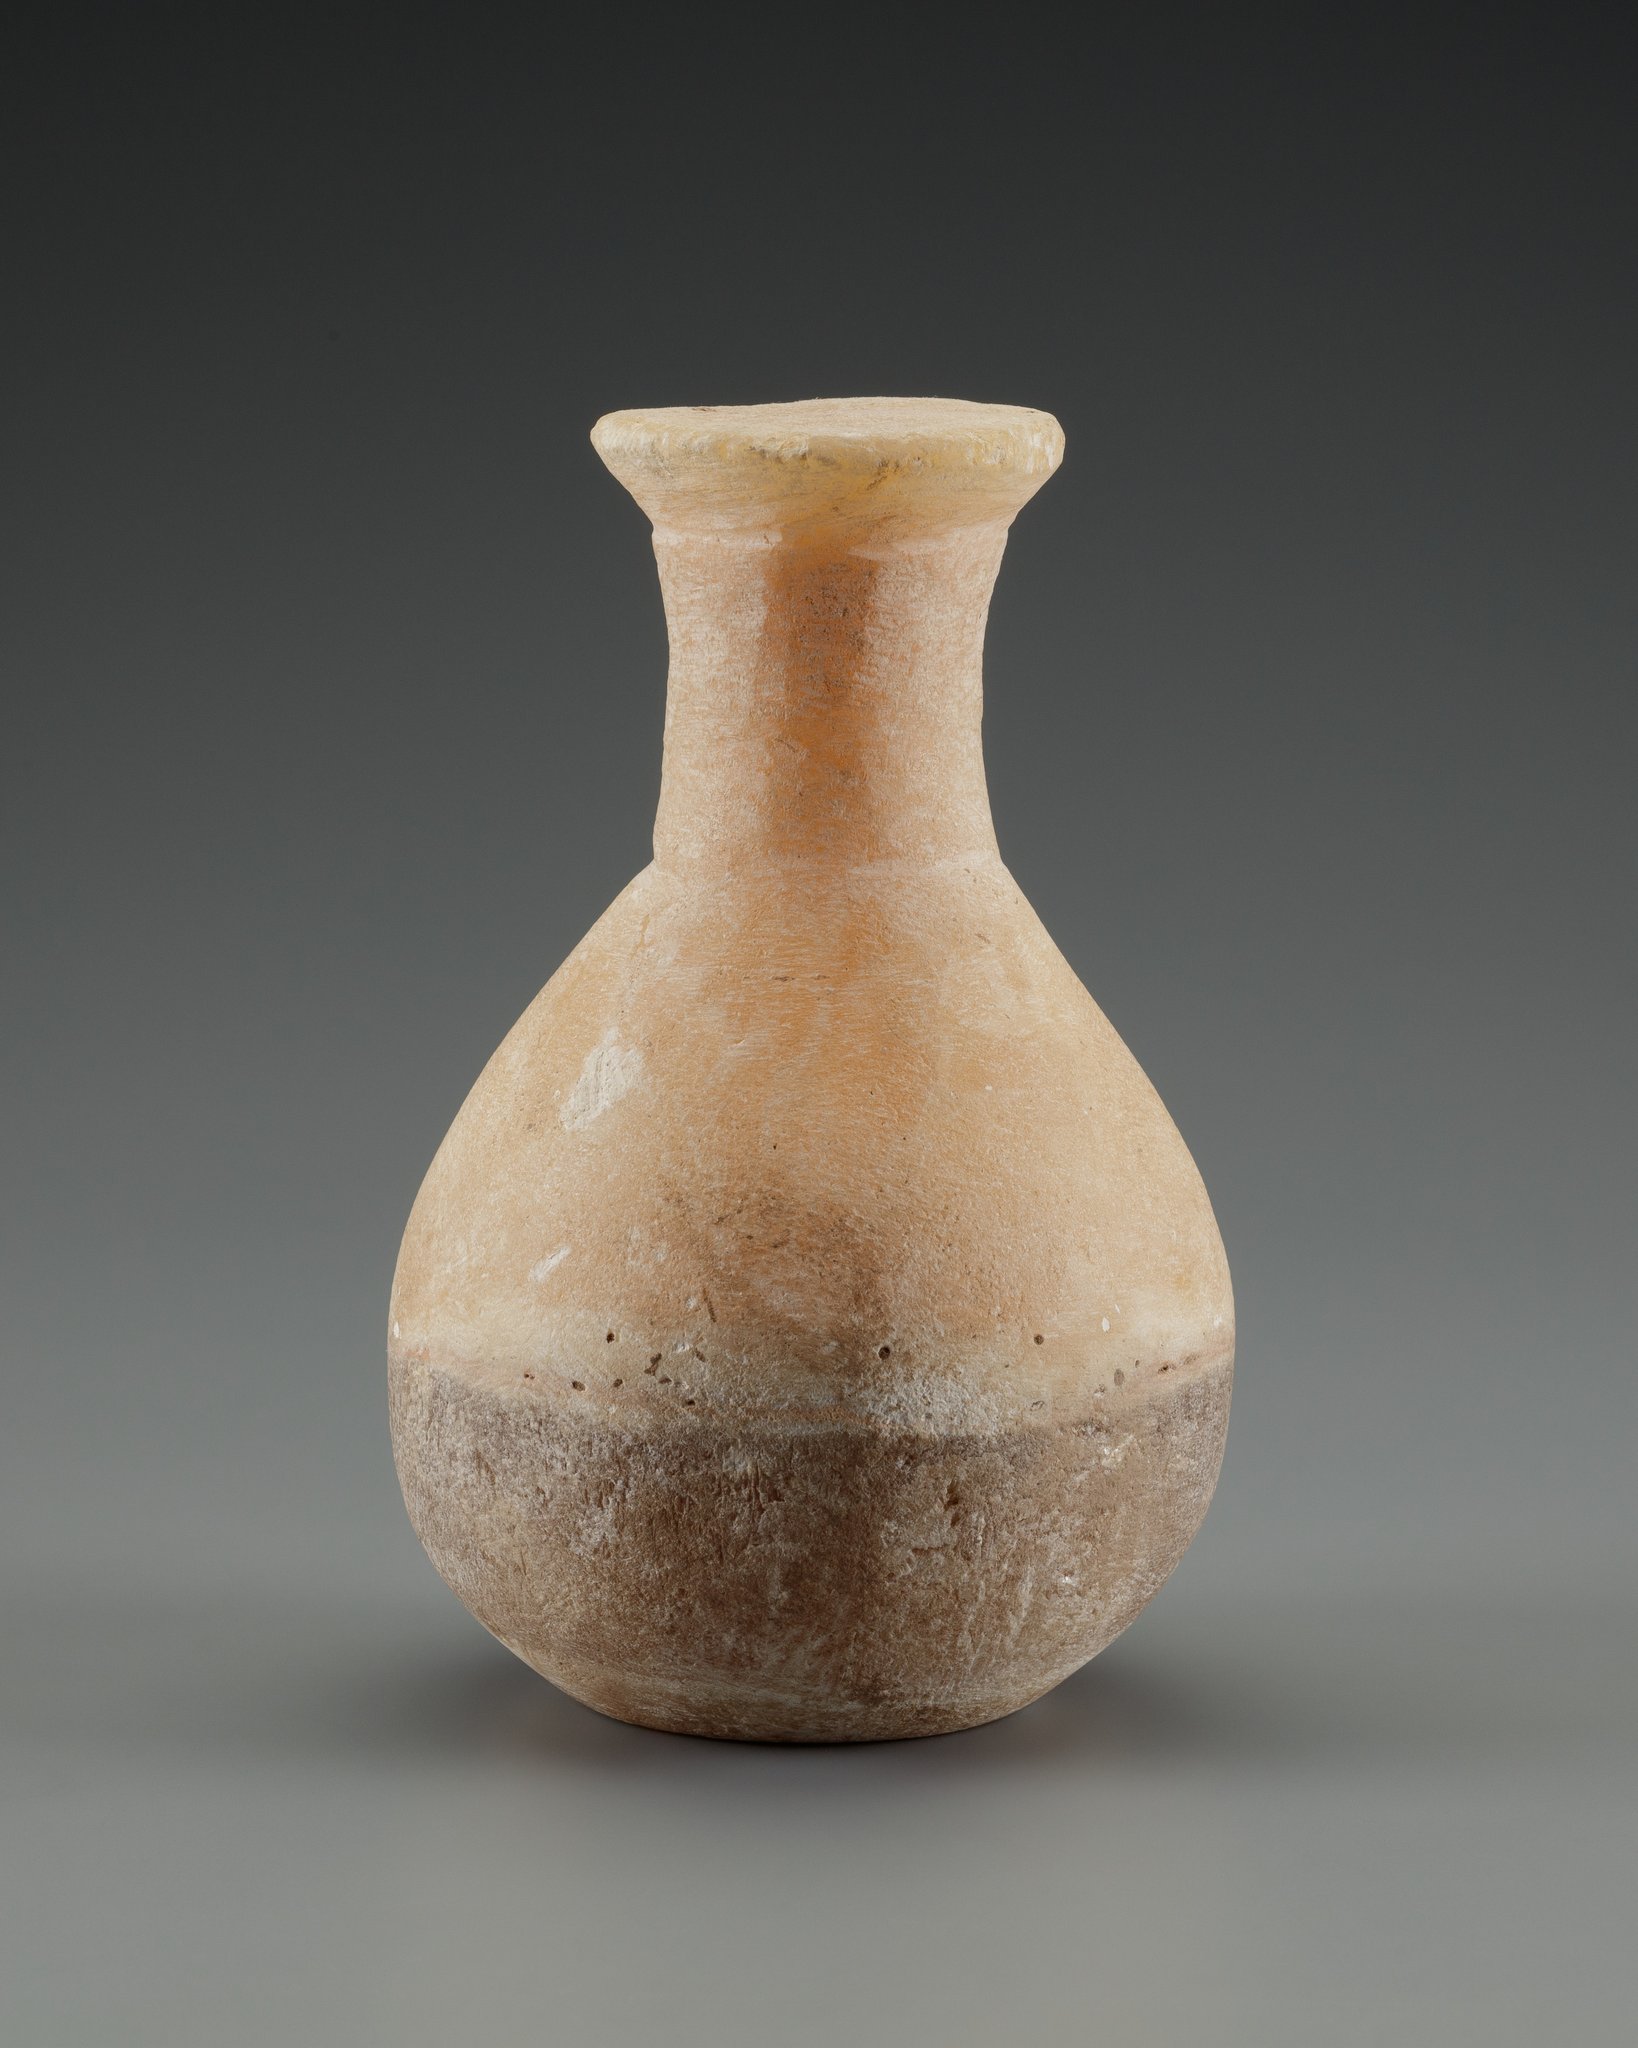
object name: jar, unbored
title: Jar with a long neck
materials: stone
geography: egypt